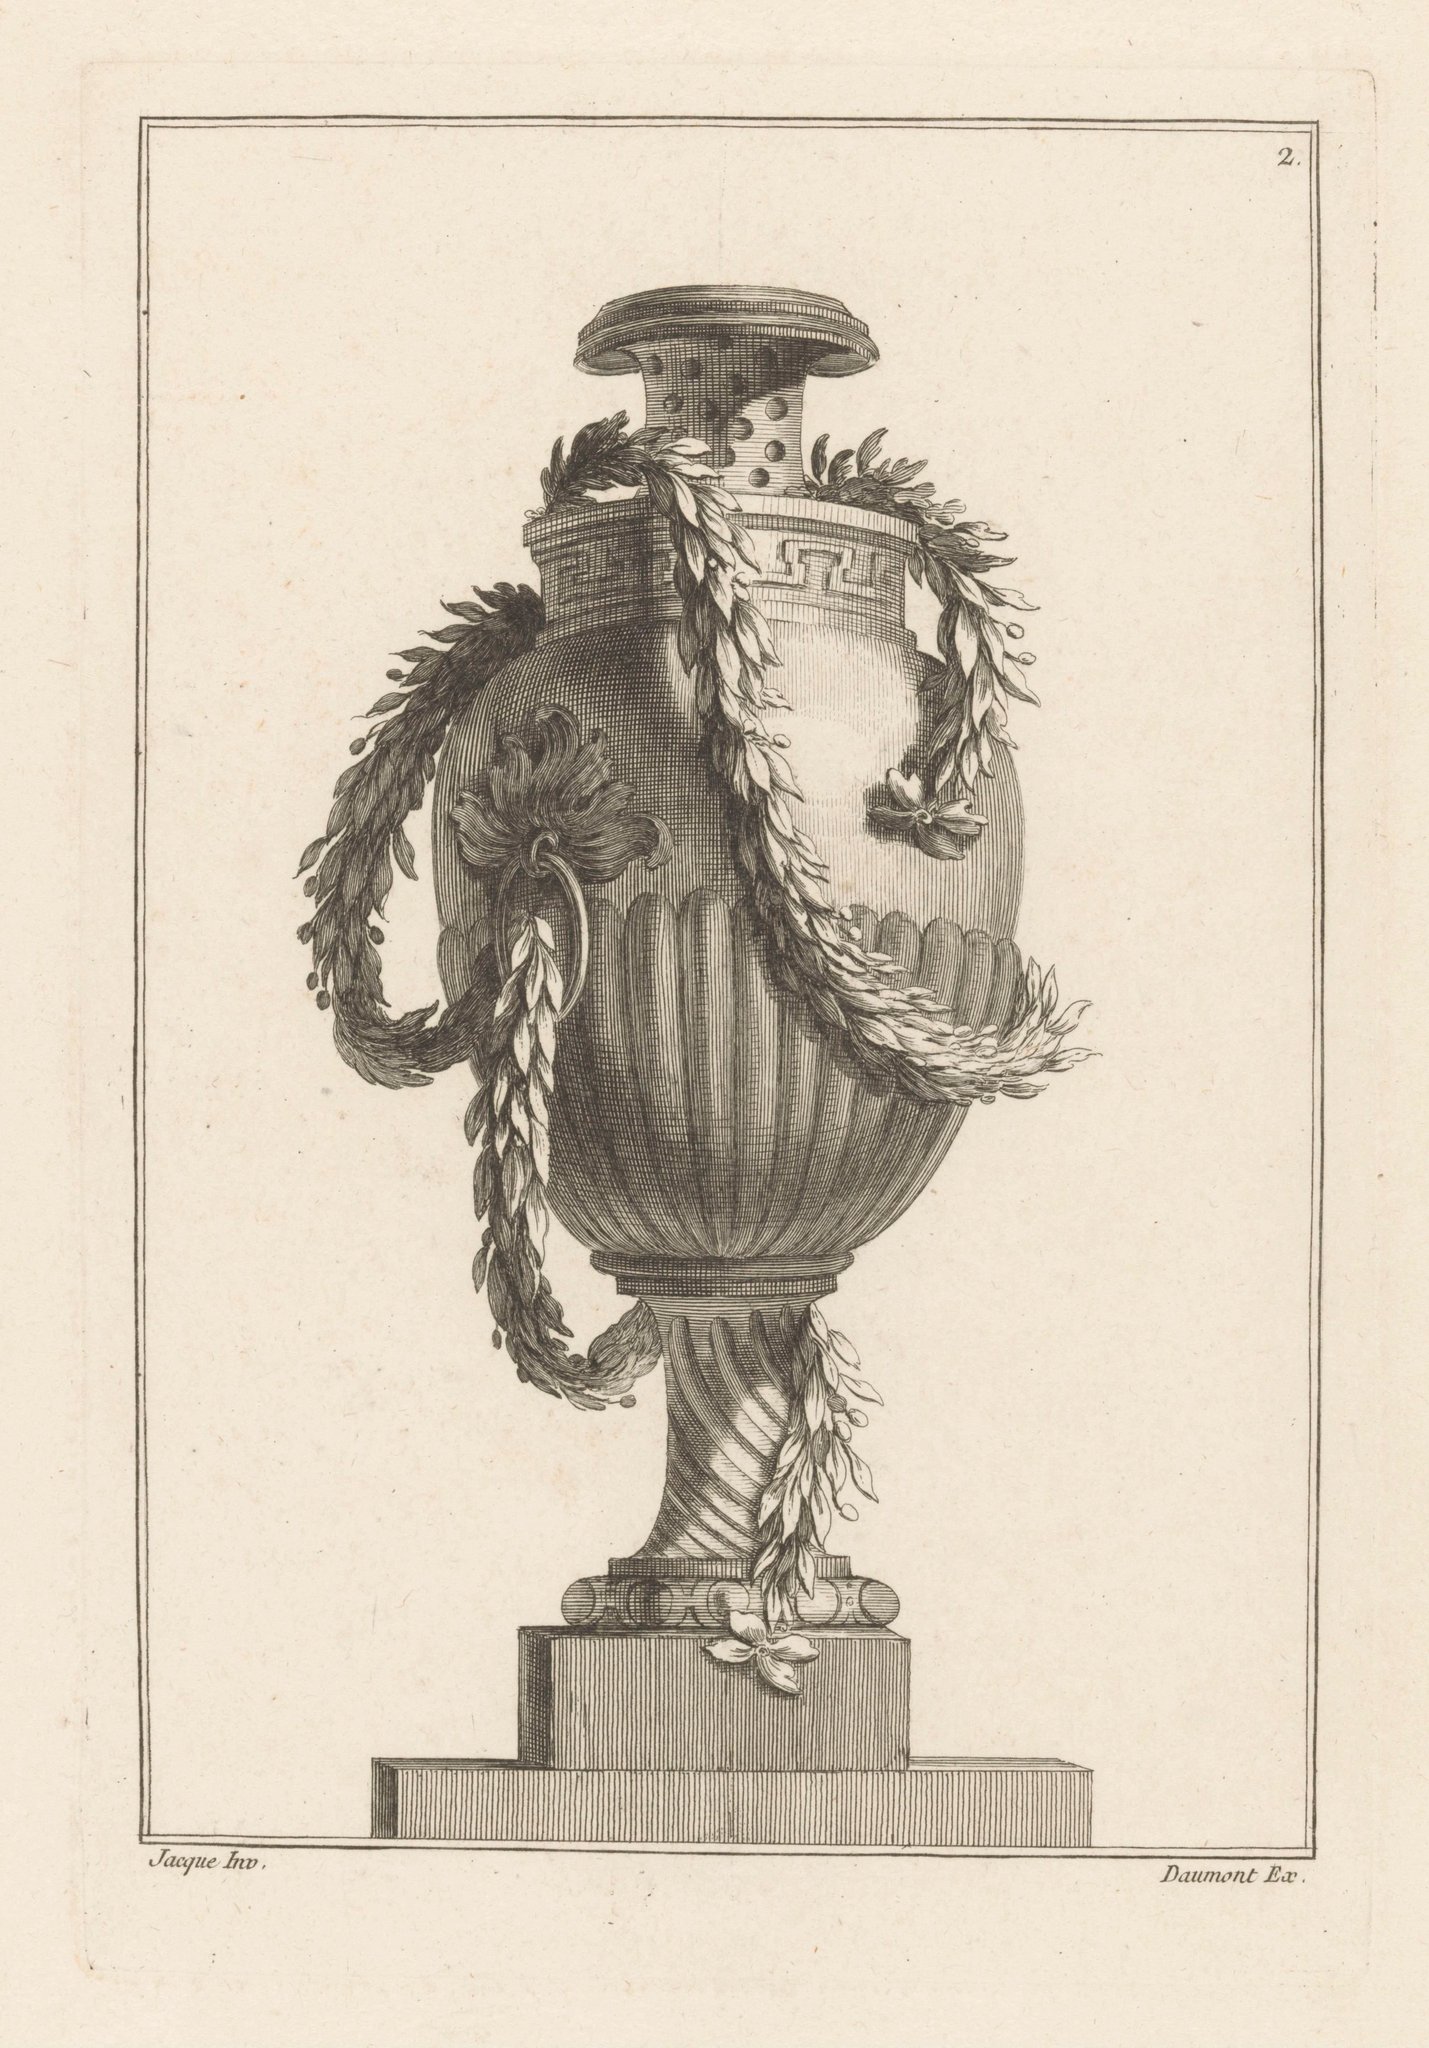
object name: ornament print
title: Vaas met ranken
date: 1745-1775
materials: paper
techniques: engraving, etching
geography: paris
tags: tendrils ~ ornament, vase ~ ornament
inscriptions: collector's mark: Lugt 2760, collector's mark: Lugt 2228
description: Een geornamenteerde vaas met ranken rondom.